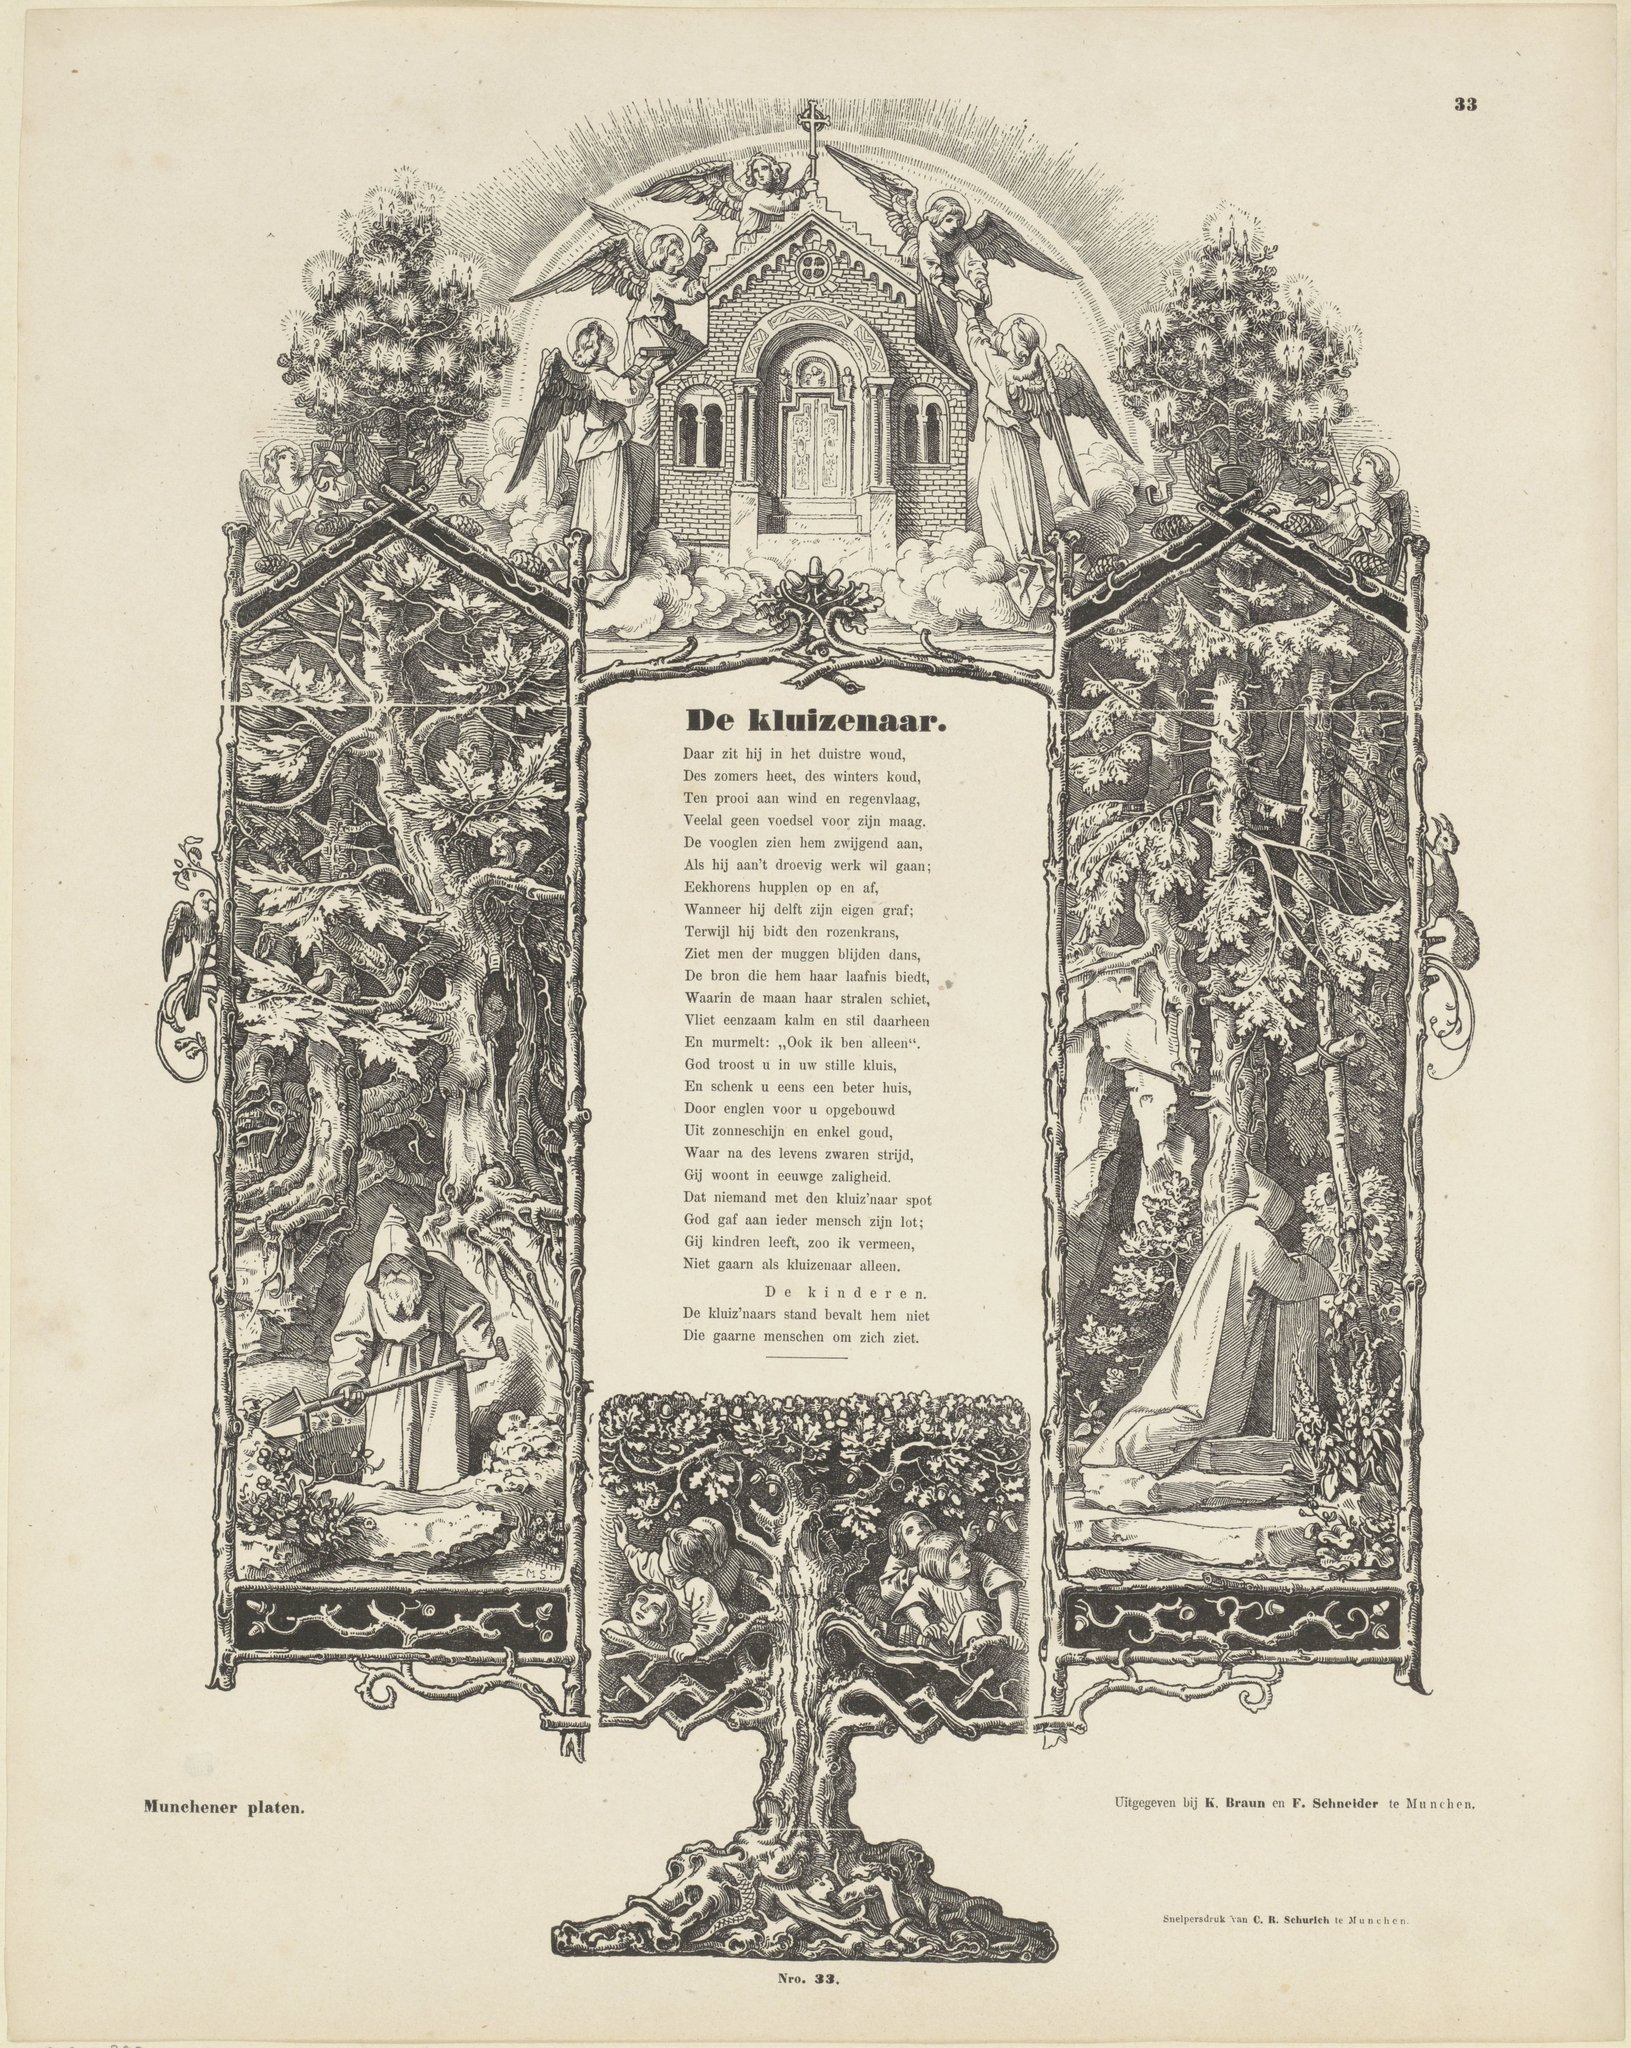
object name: print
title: De kluizenaar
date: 1843-1920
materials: paper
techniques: letterpress printing, engraving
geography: germany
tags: anchorite, hermit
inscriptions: collector's mark: Lugt 2760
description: Lofzang op een kluizenaar in het bos. Een triptiek van takken met op het centrale paneel een vers. Op de vleugels voorstellingen van de kluizenaar in het bos. Op de top een kerk omringd door engelen. Genummerd midden onder: Nro. 33. Genummerd rechtsboven: 33.